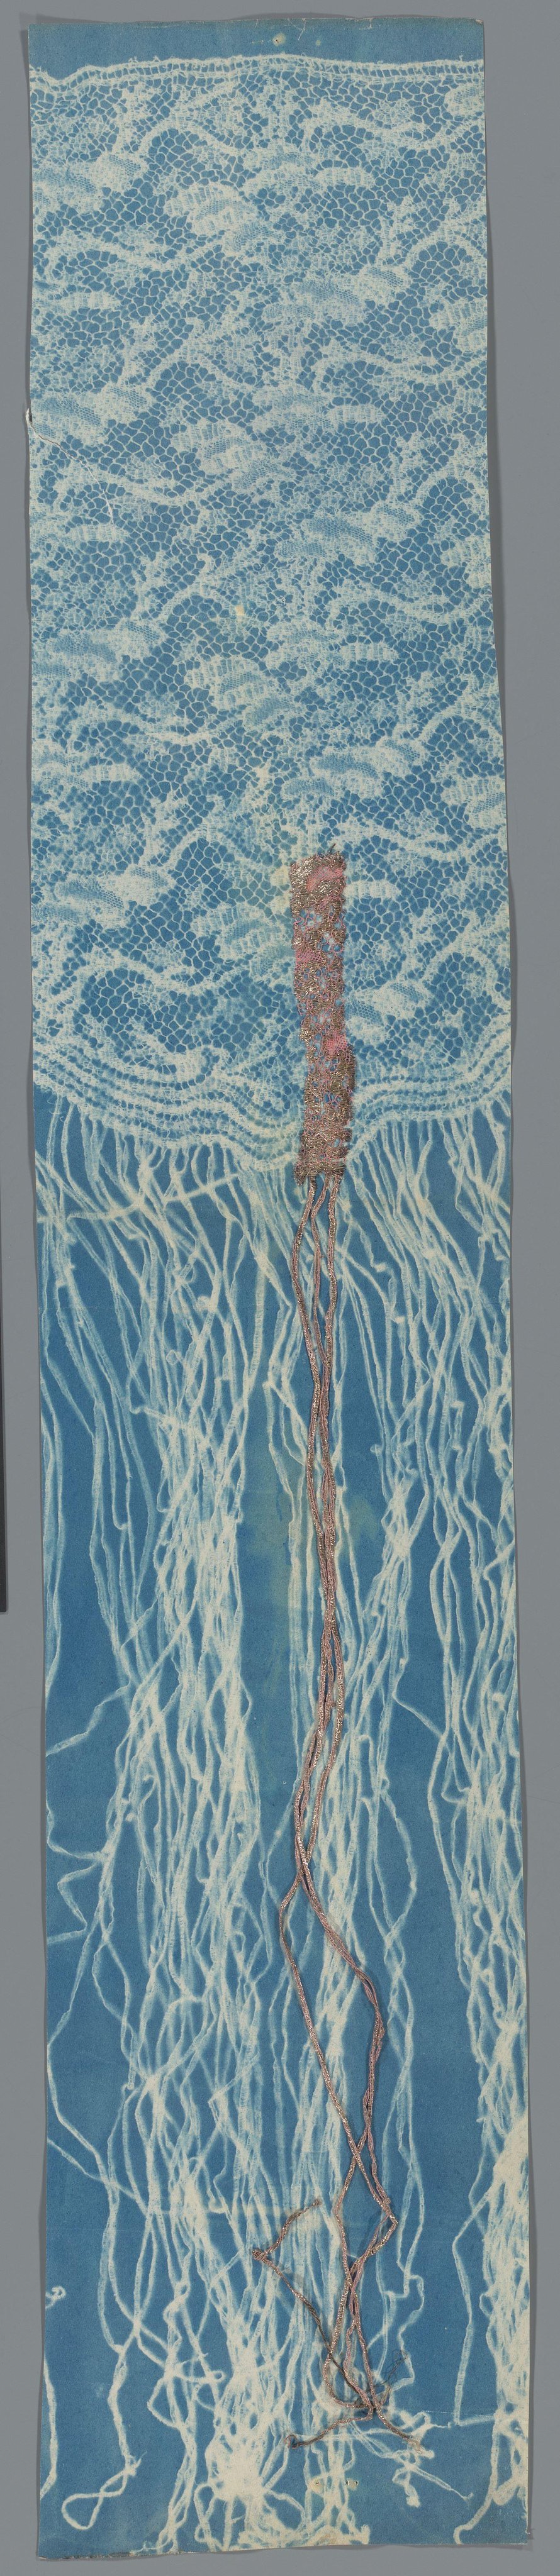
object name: photogram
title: Collar made of gauze or tulle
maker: Anonymous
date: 1900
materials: paper, photographic support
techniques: cyanotype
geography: france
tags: lace